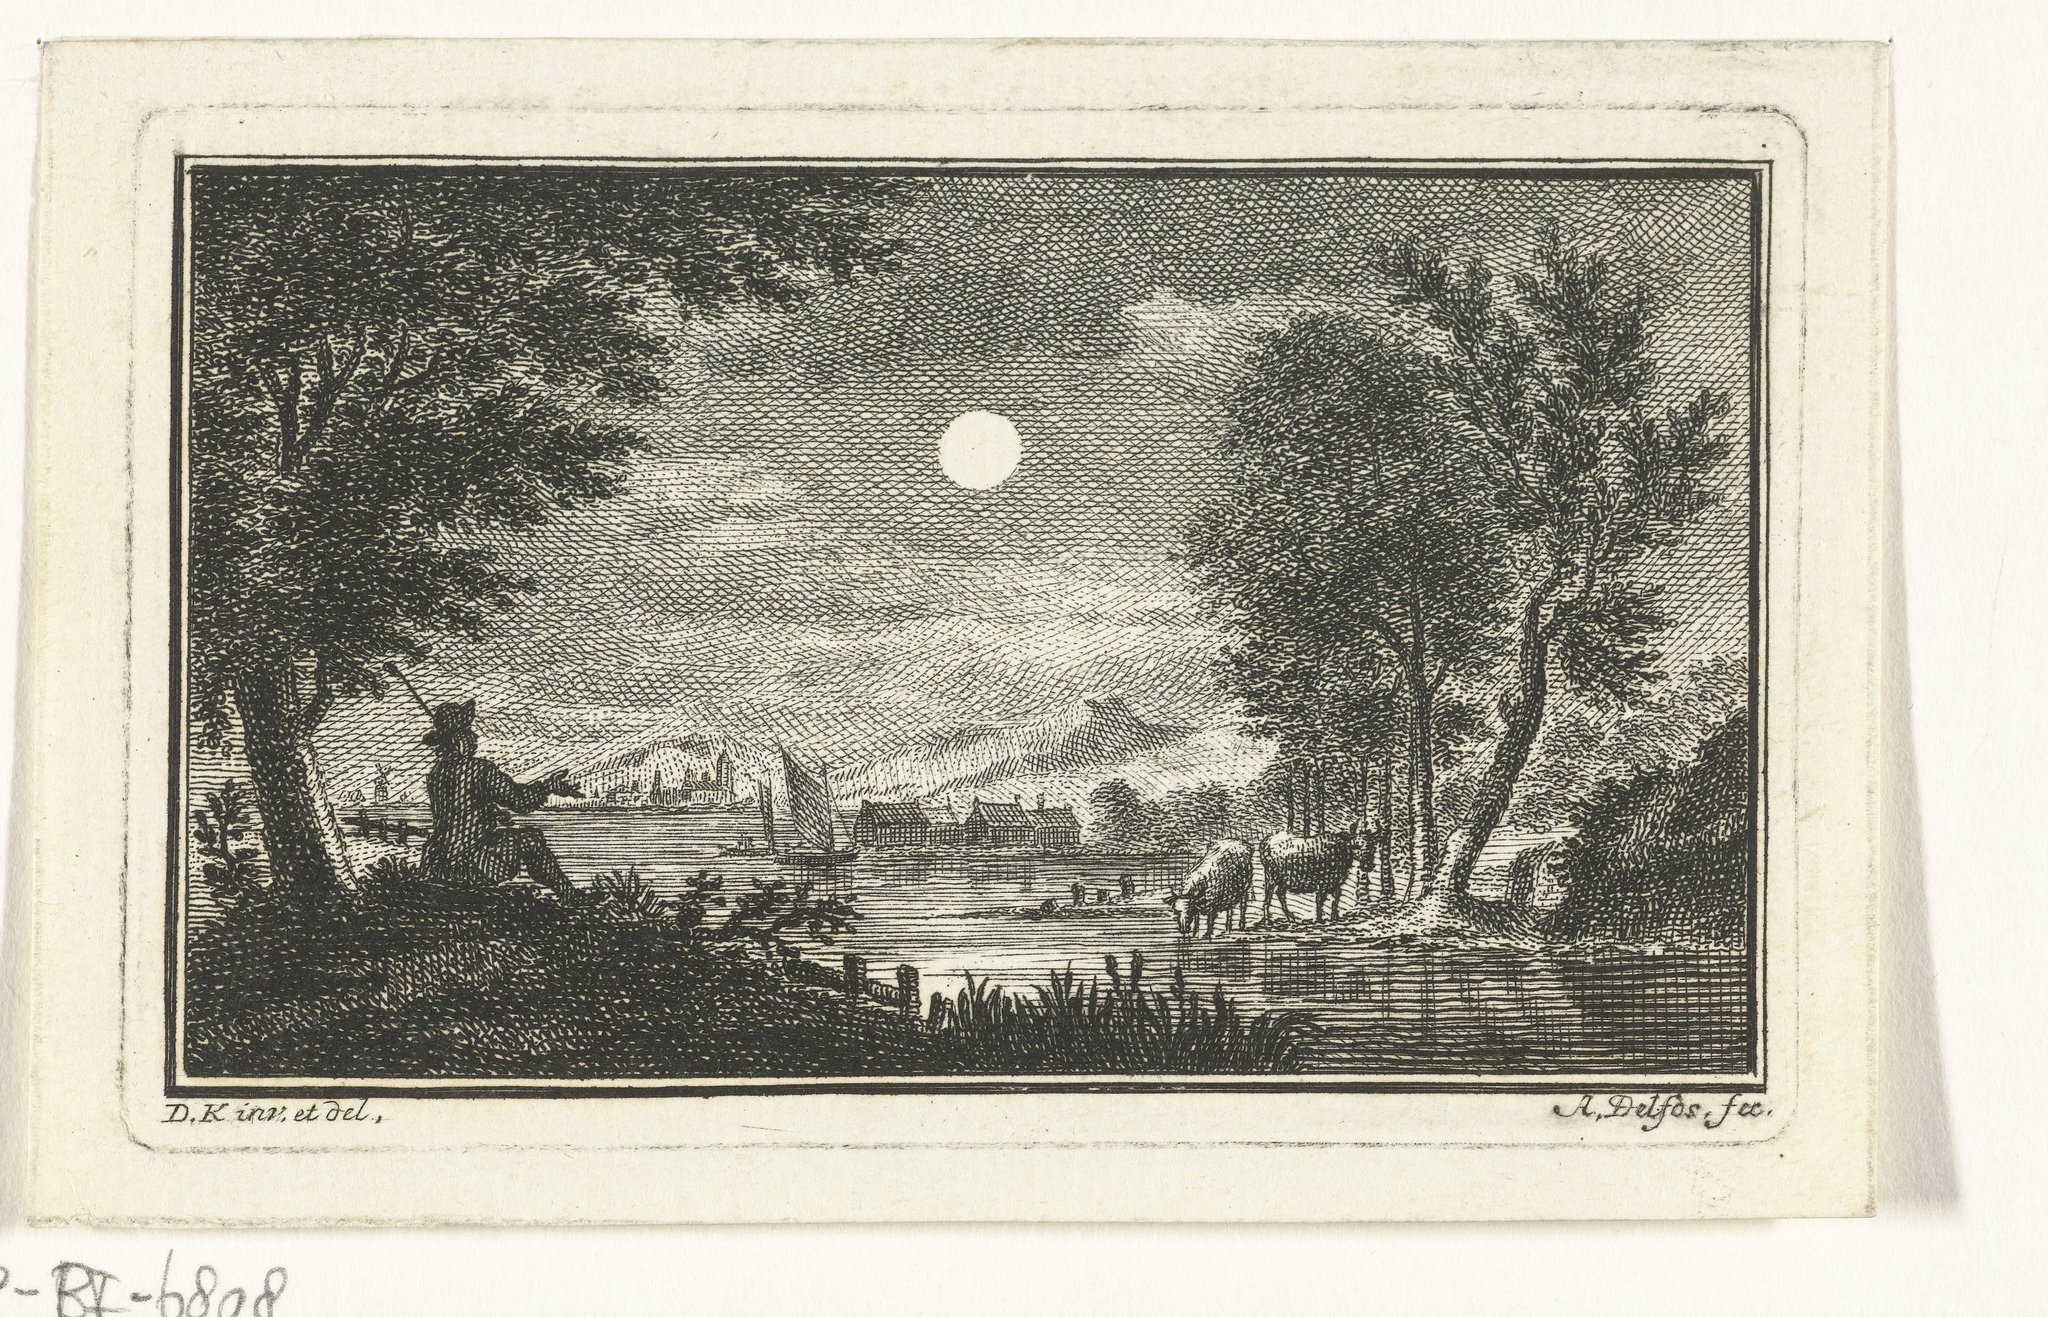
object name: print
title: Riviergezicht met herder in maanlicht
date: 1741-1820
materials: paper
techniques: etching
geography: leiden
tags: moonlight, (high) hill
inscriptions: collector's mark: Lugt 240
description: Prent gebruikt als boekillustratie maar onbekend in welke uitgave van auteur Dirk Kuipers.